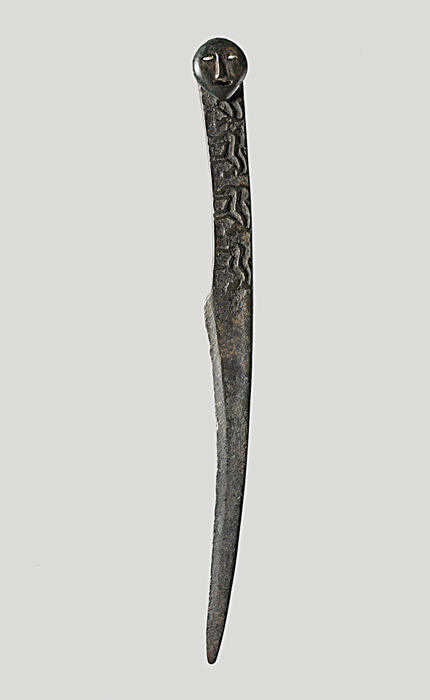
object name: knife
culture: china or mongolia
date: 800-701 BCE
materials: bronze